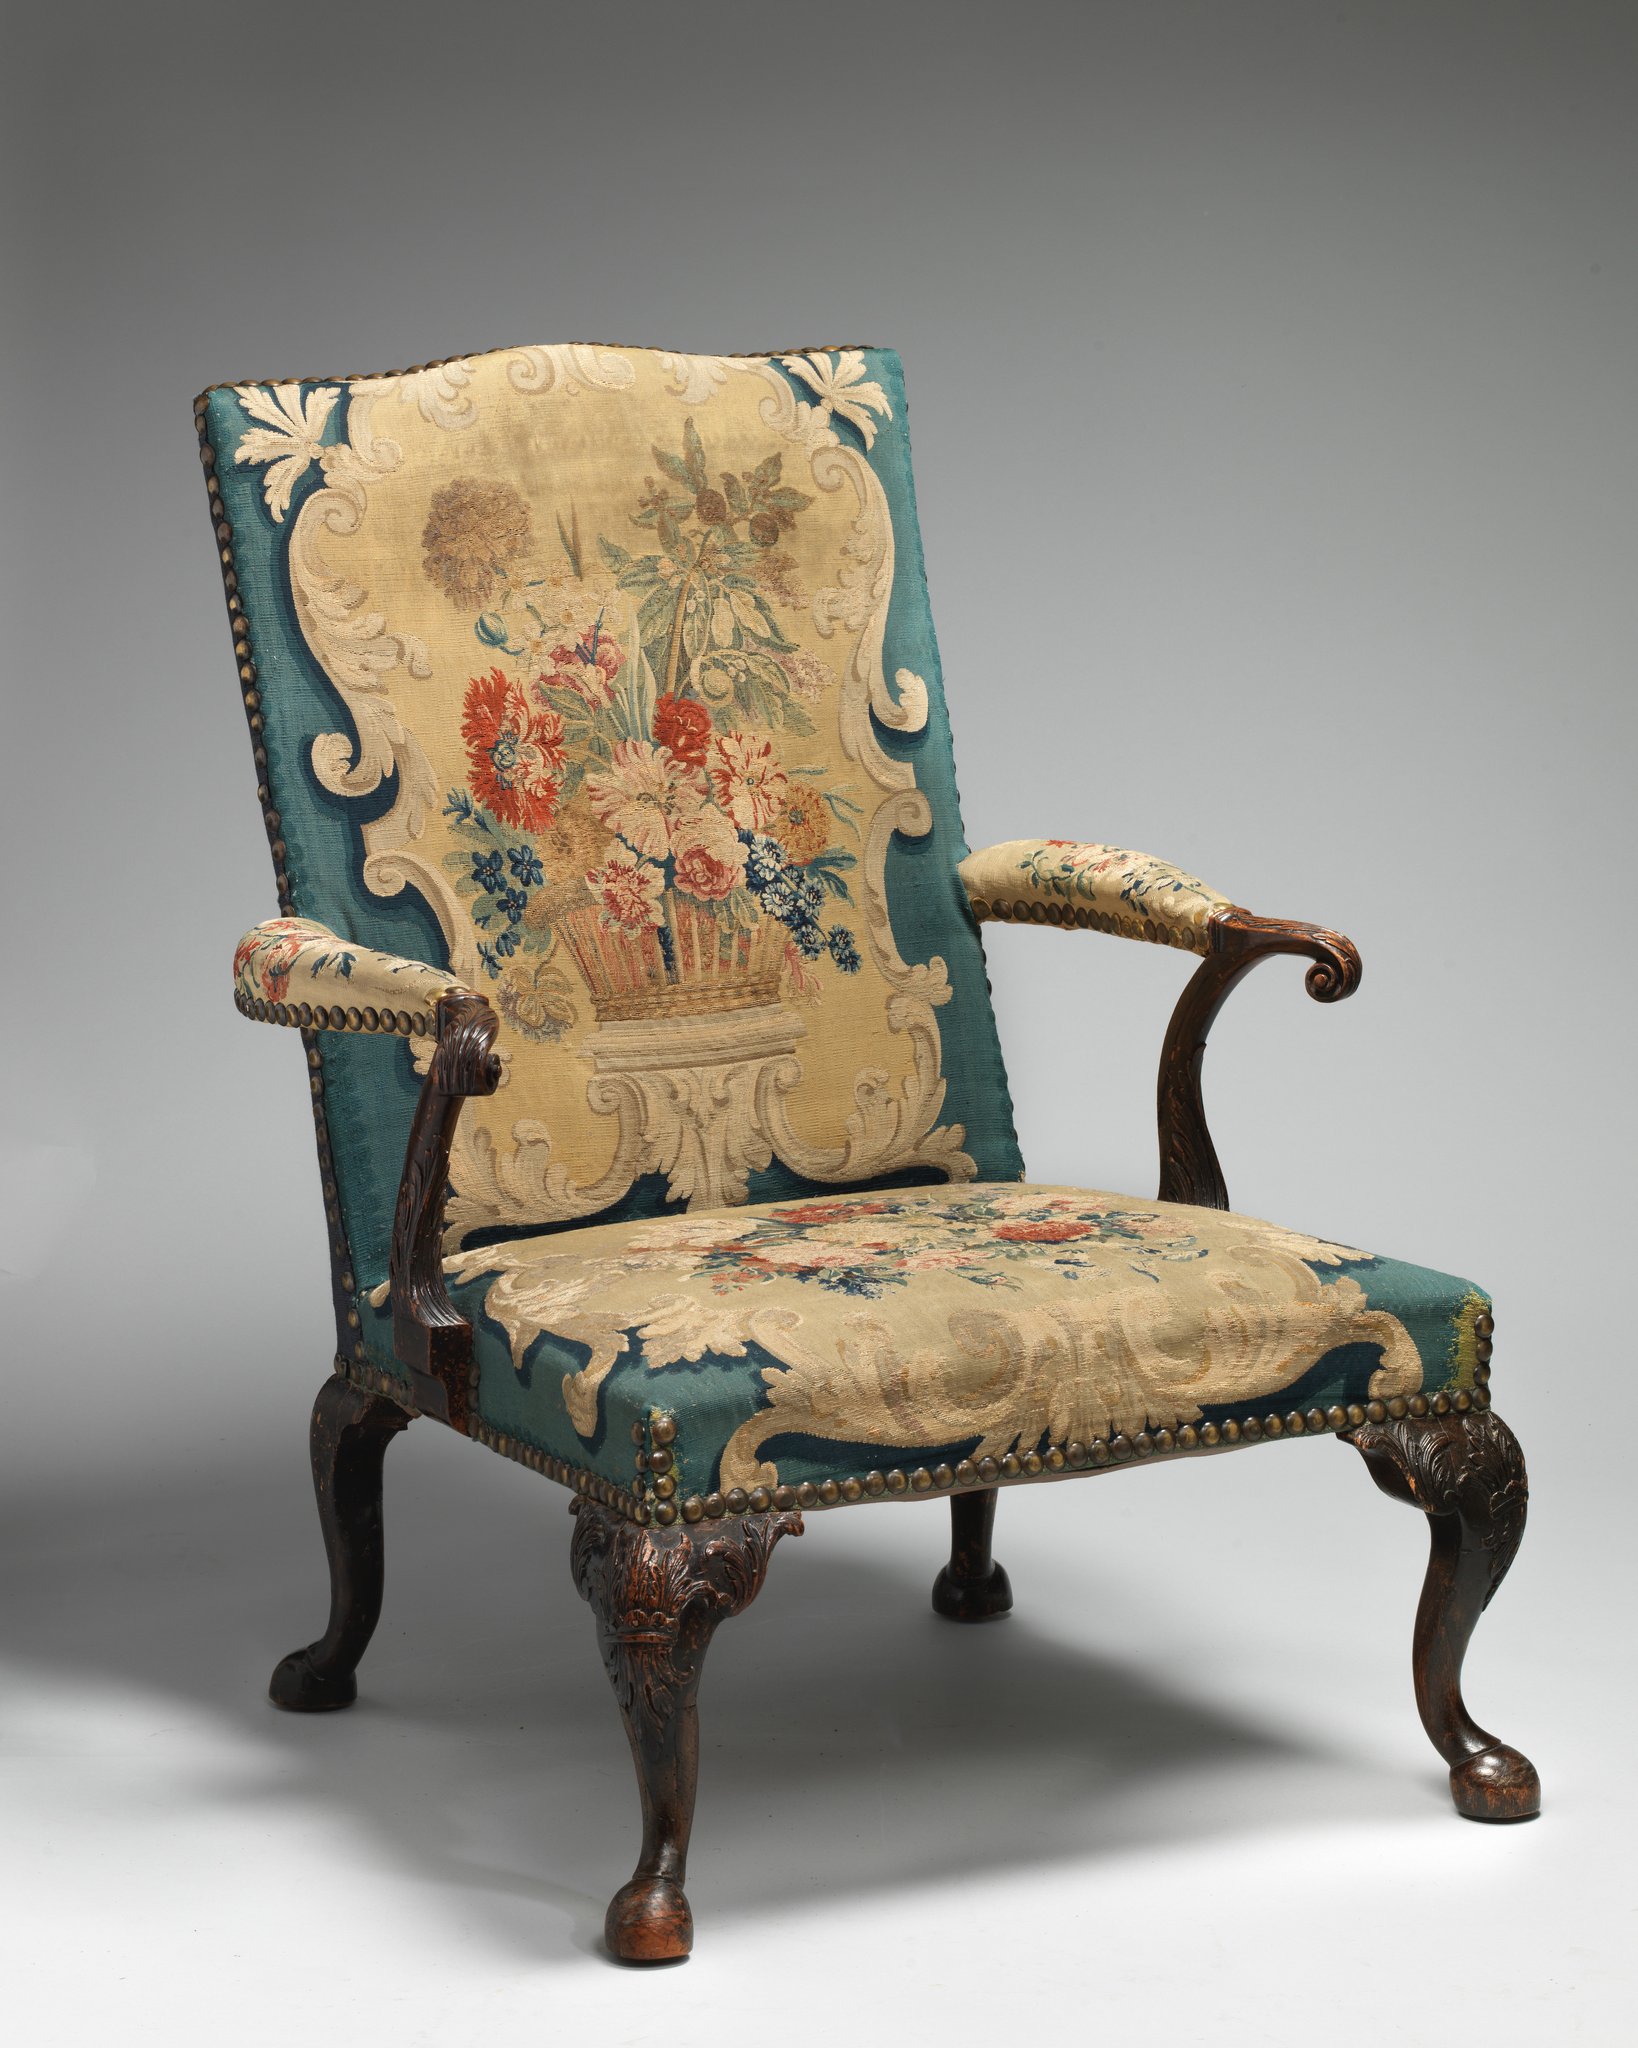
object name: armchair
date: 1740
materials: wood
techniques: tapestry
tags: flowers